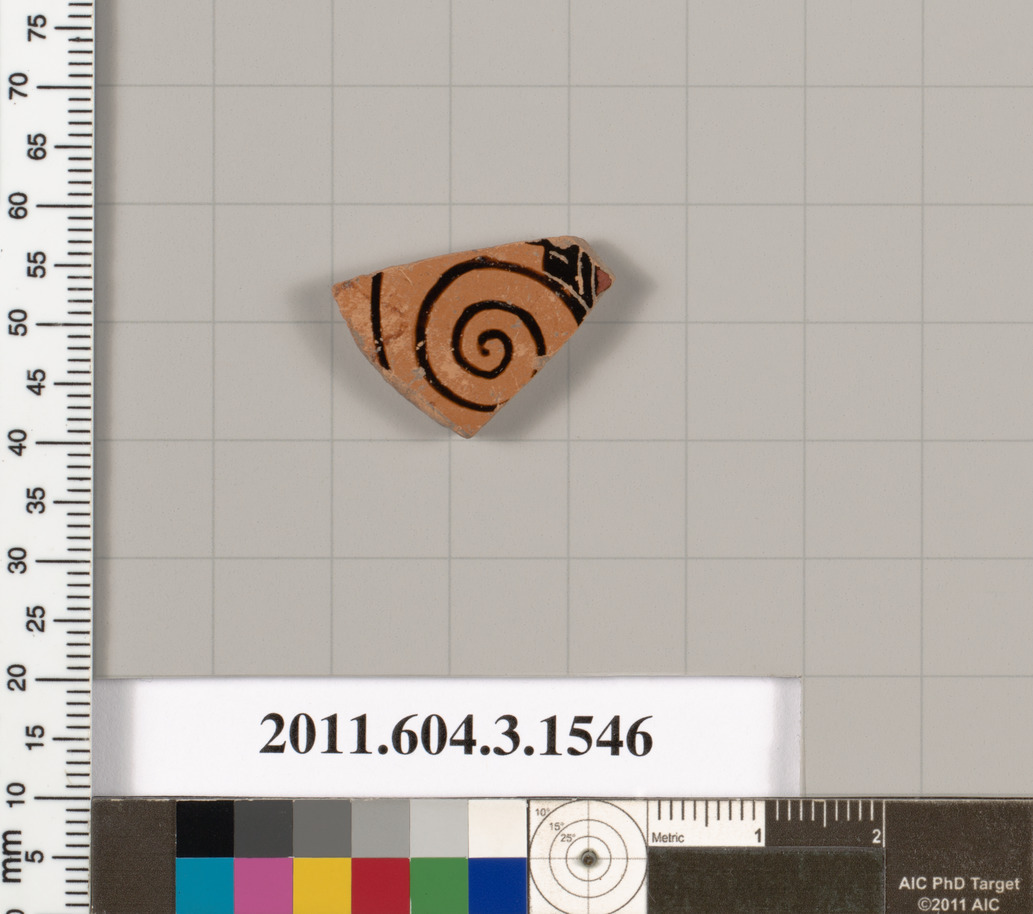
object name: kylix fragment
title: Terracotta fragment of a kylix (drinking cup)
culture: greek, attic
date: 550-526 BCE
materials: terracotta